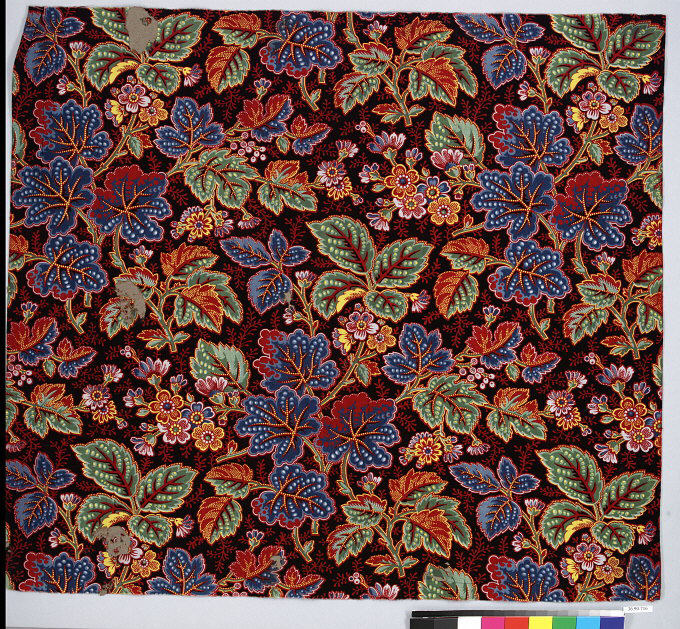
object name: piece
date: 1867-1900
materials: cotton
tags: flowers,leaves